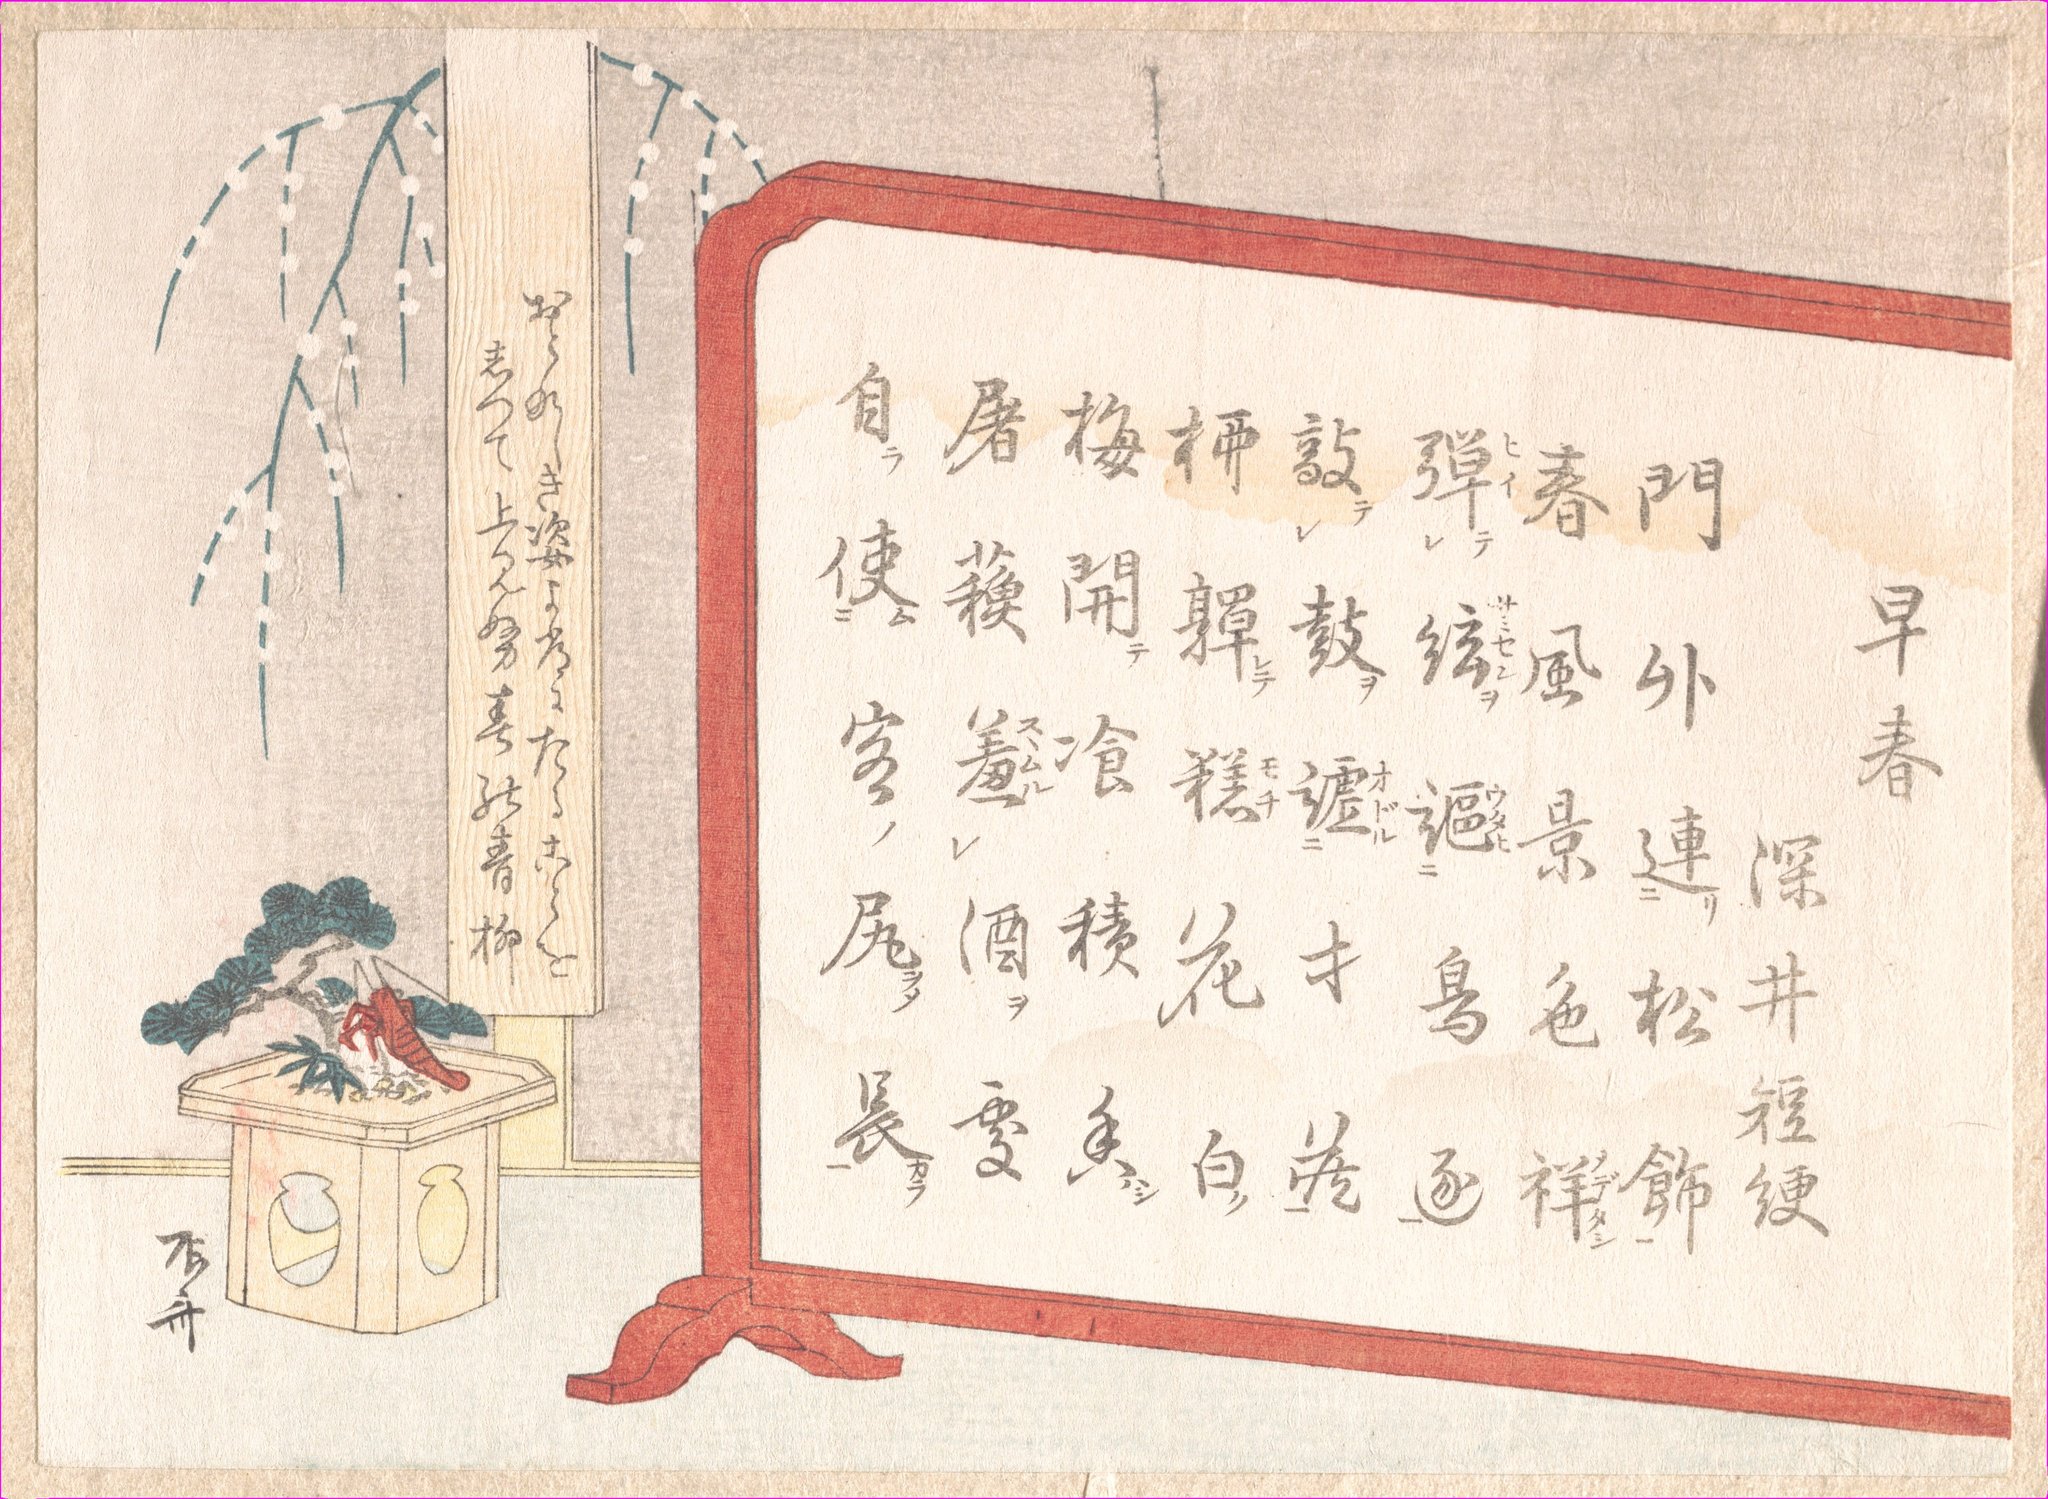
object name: print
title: Screen of Calligraphy and New Year Decoration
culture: japanese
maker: ryūryūkyo shinsai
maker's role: artist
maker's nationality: japanese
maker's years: 1799-1823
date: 1801-1900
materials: ink, paper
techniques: surimono, woodblock print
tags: screens